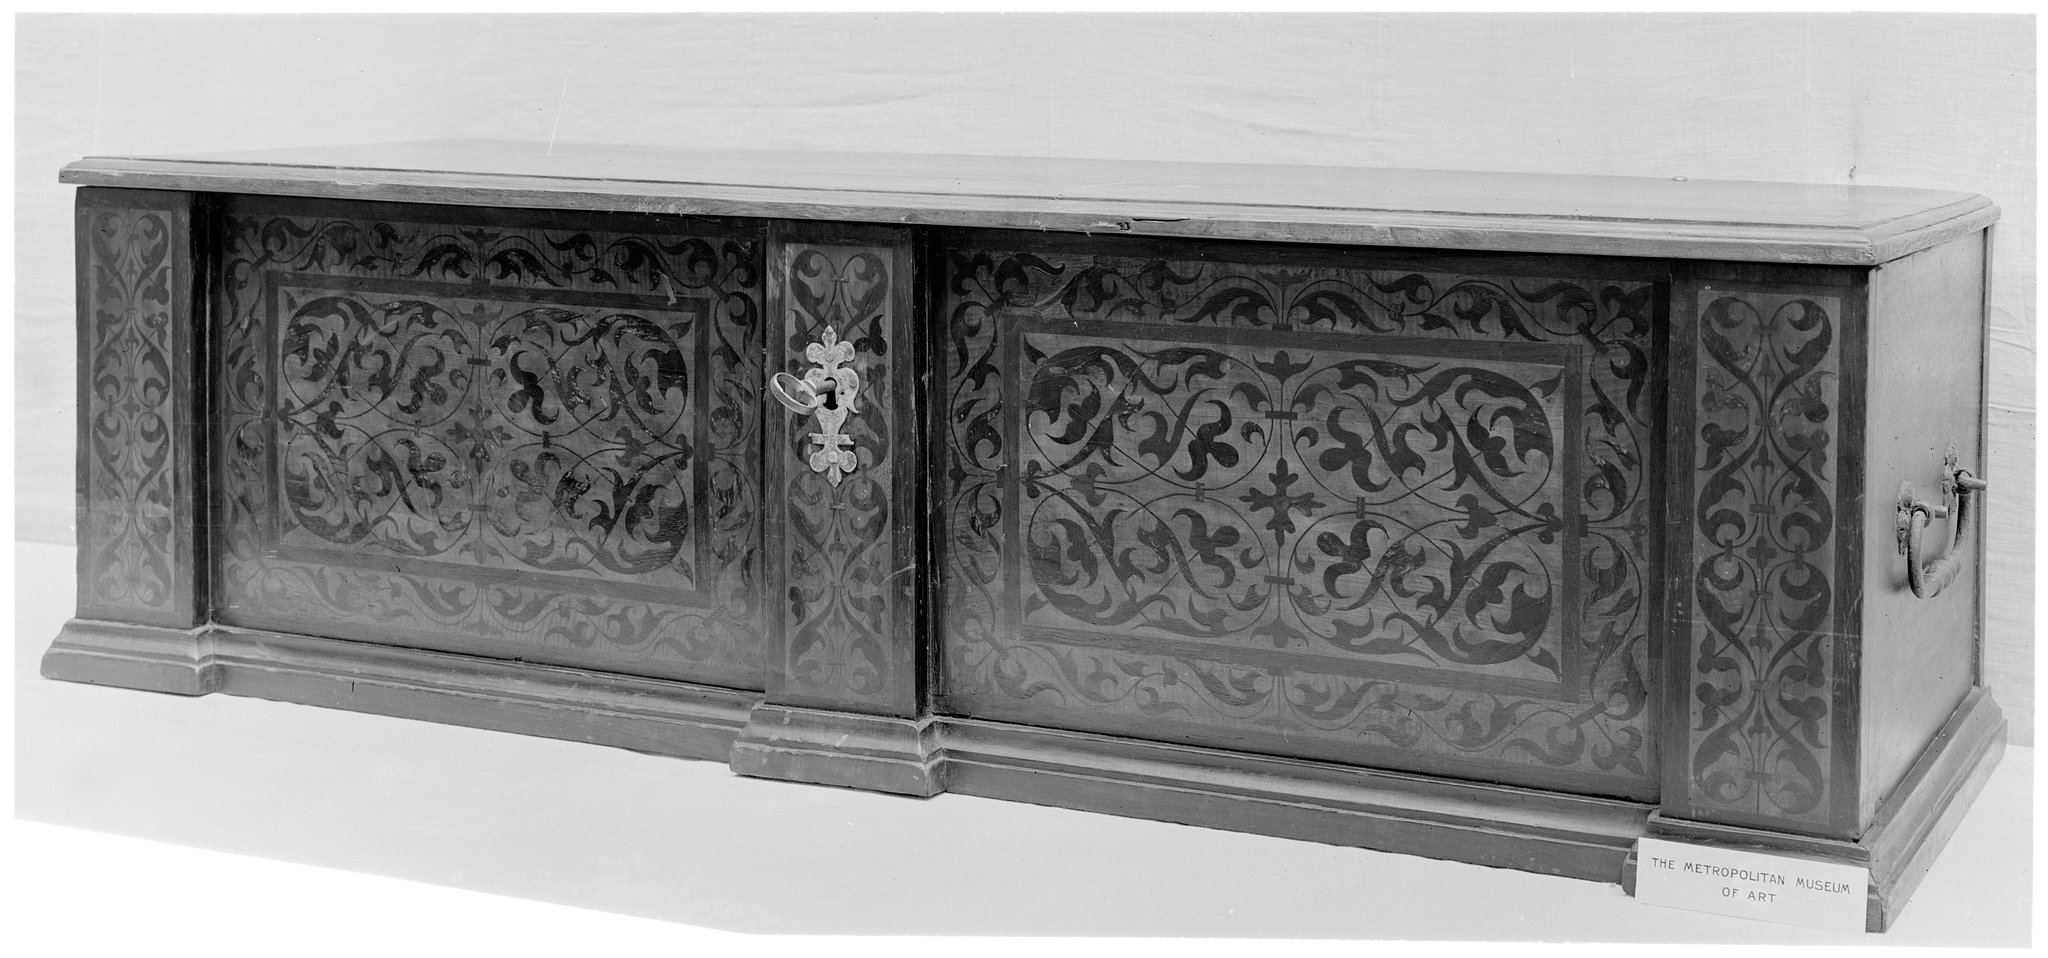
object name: chest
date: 1588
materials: wood